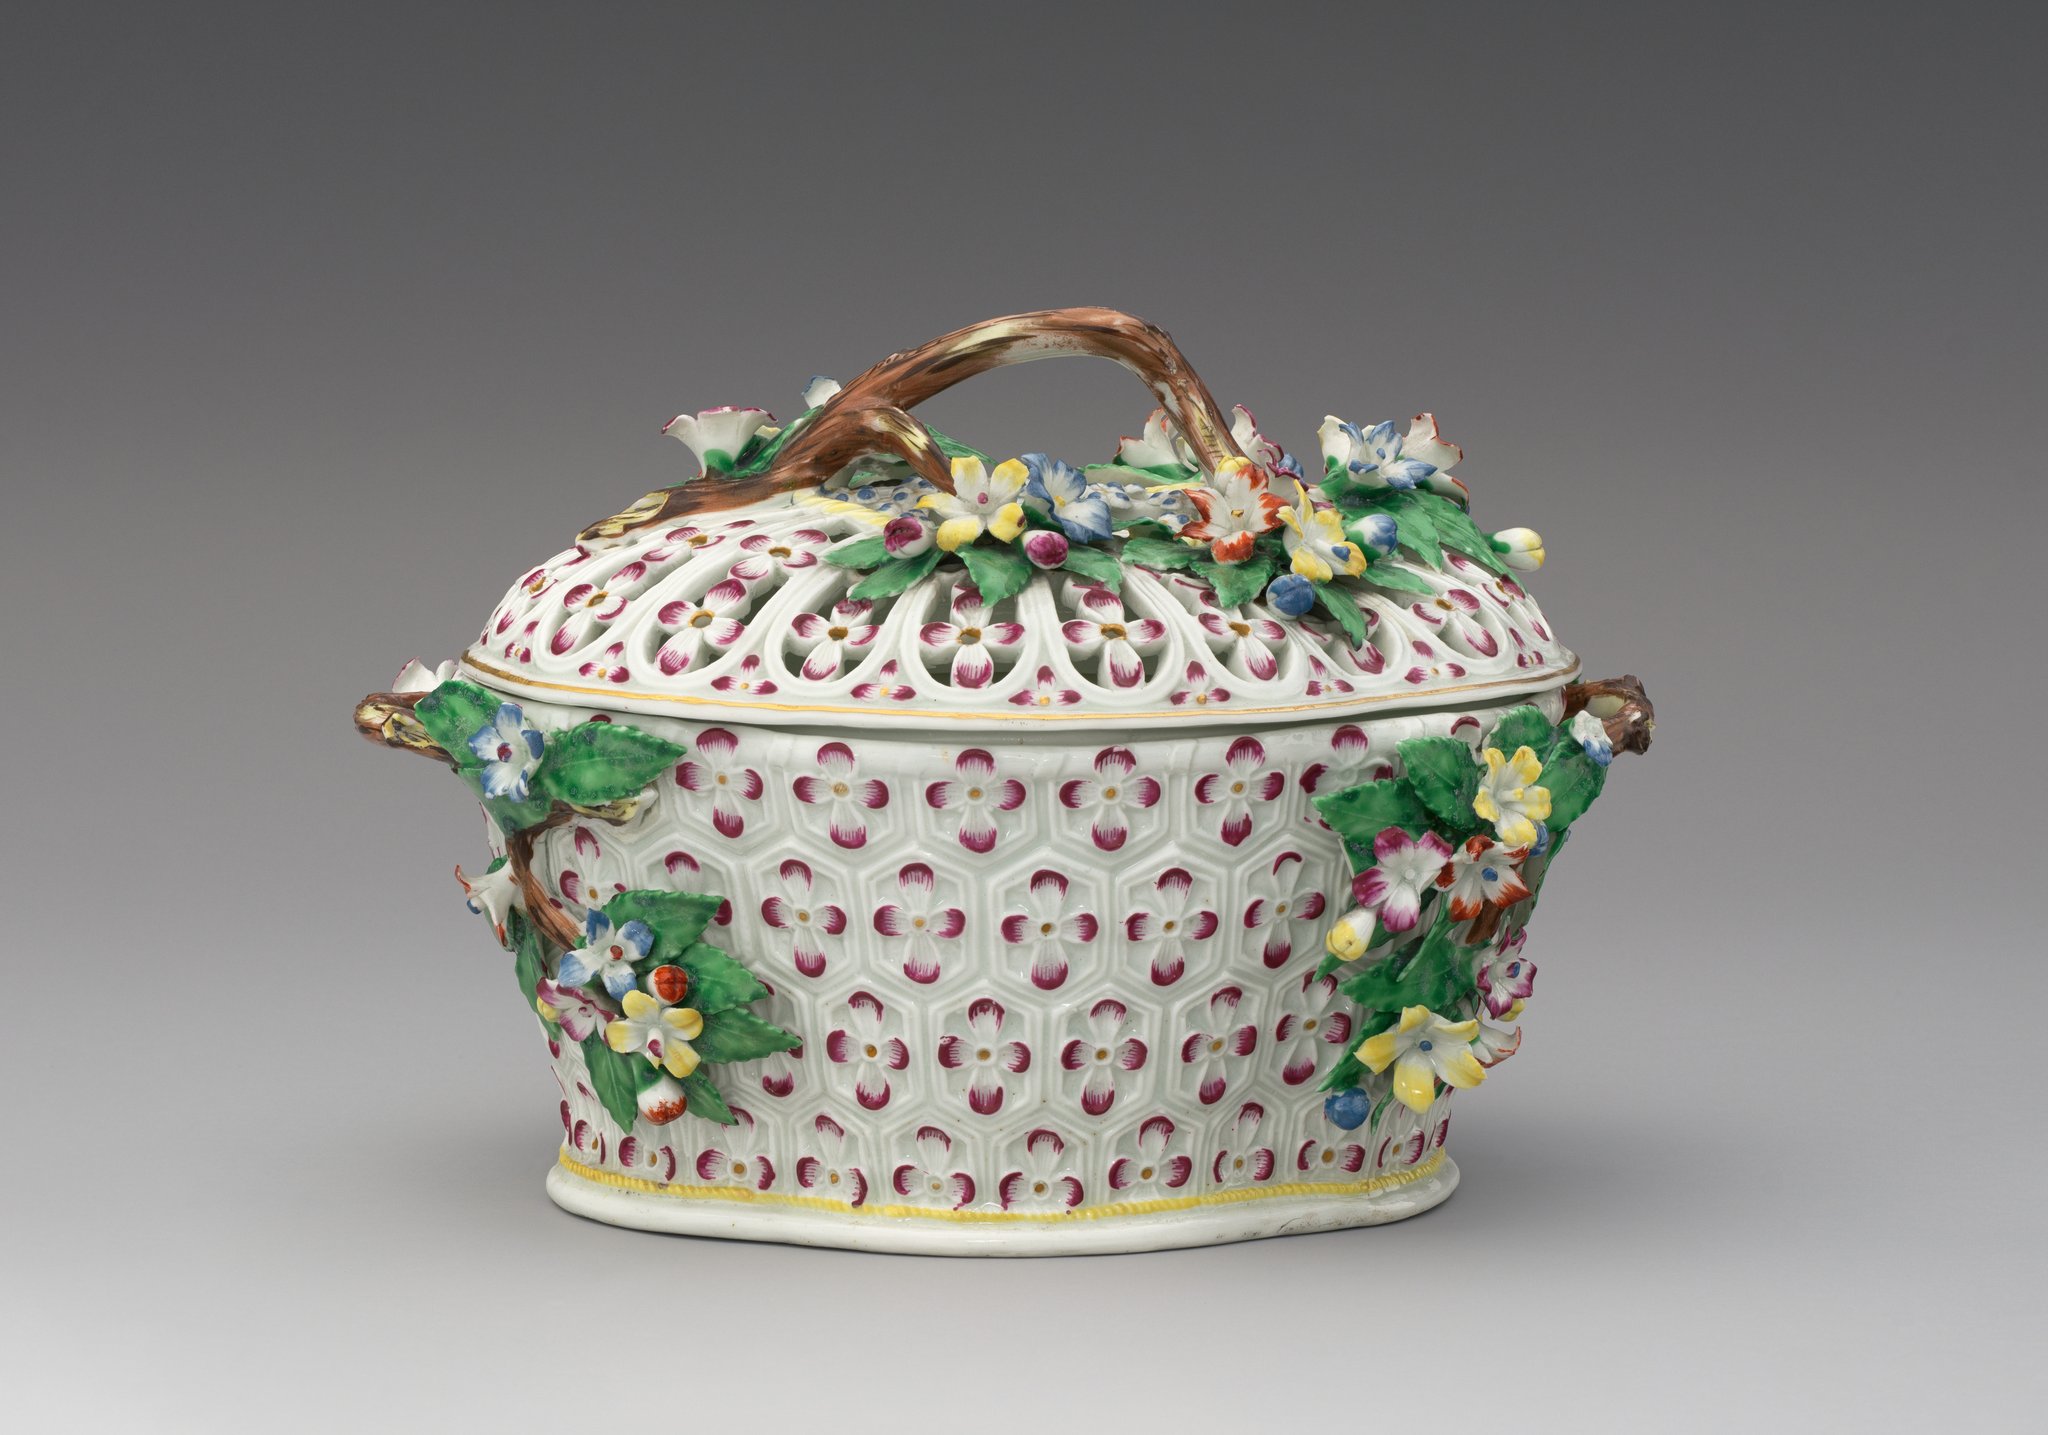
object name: dessert basket with cover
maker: worcester factory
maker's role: factory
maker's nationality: british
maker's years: 1751-2008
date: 1770-1780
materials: soft paste porcelain